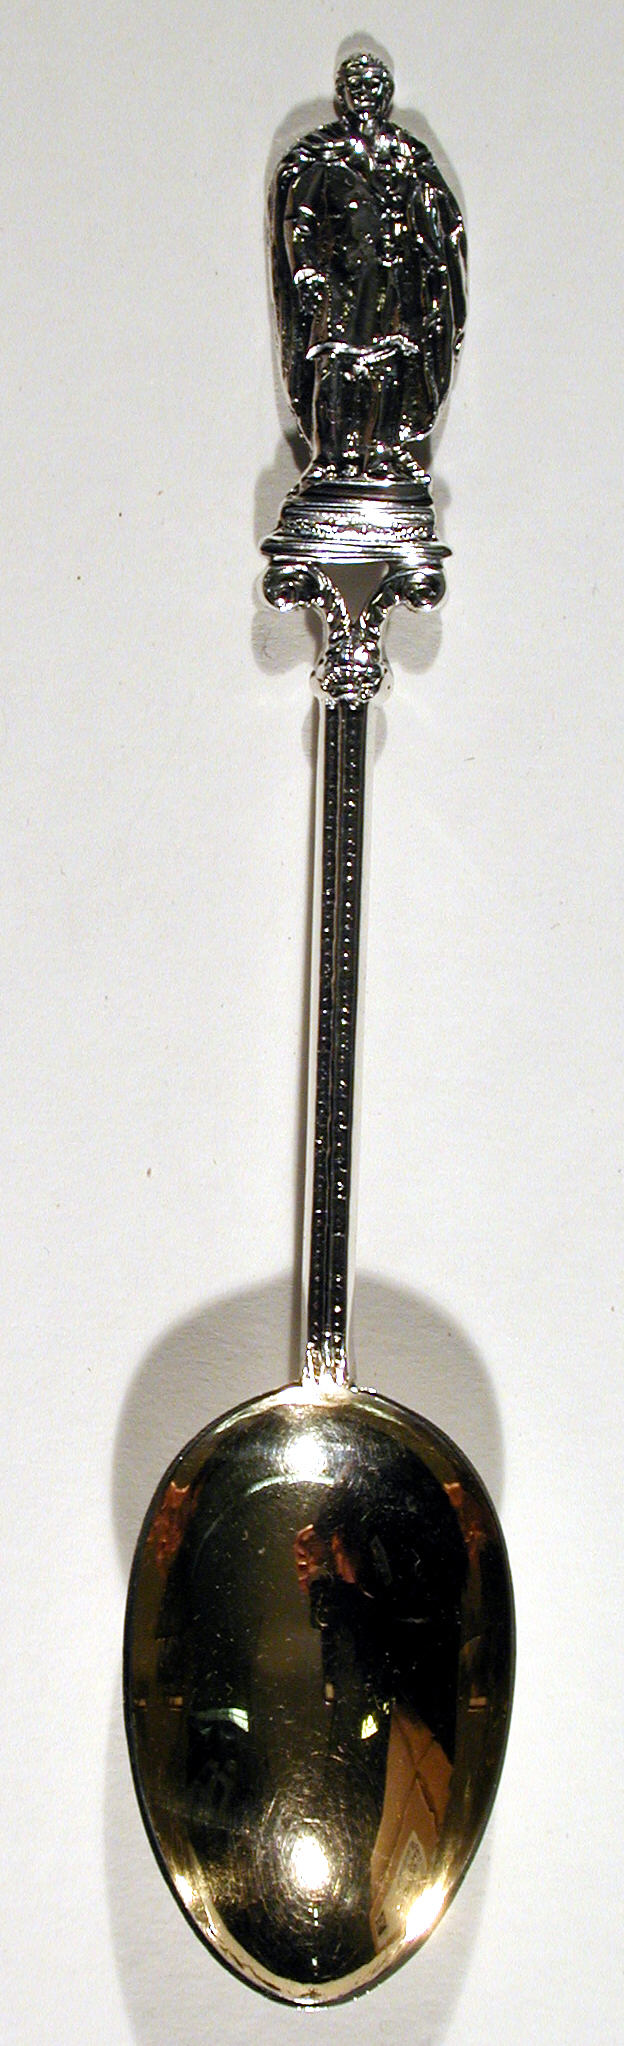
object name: souvenir spoon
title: Souvenir spoon with finial in form of an academic or peer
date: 1895-1896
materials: gilt, silver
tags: men